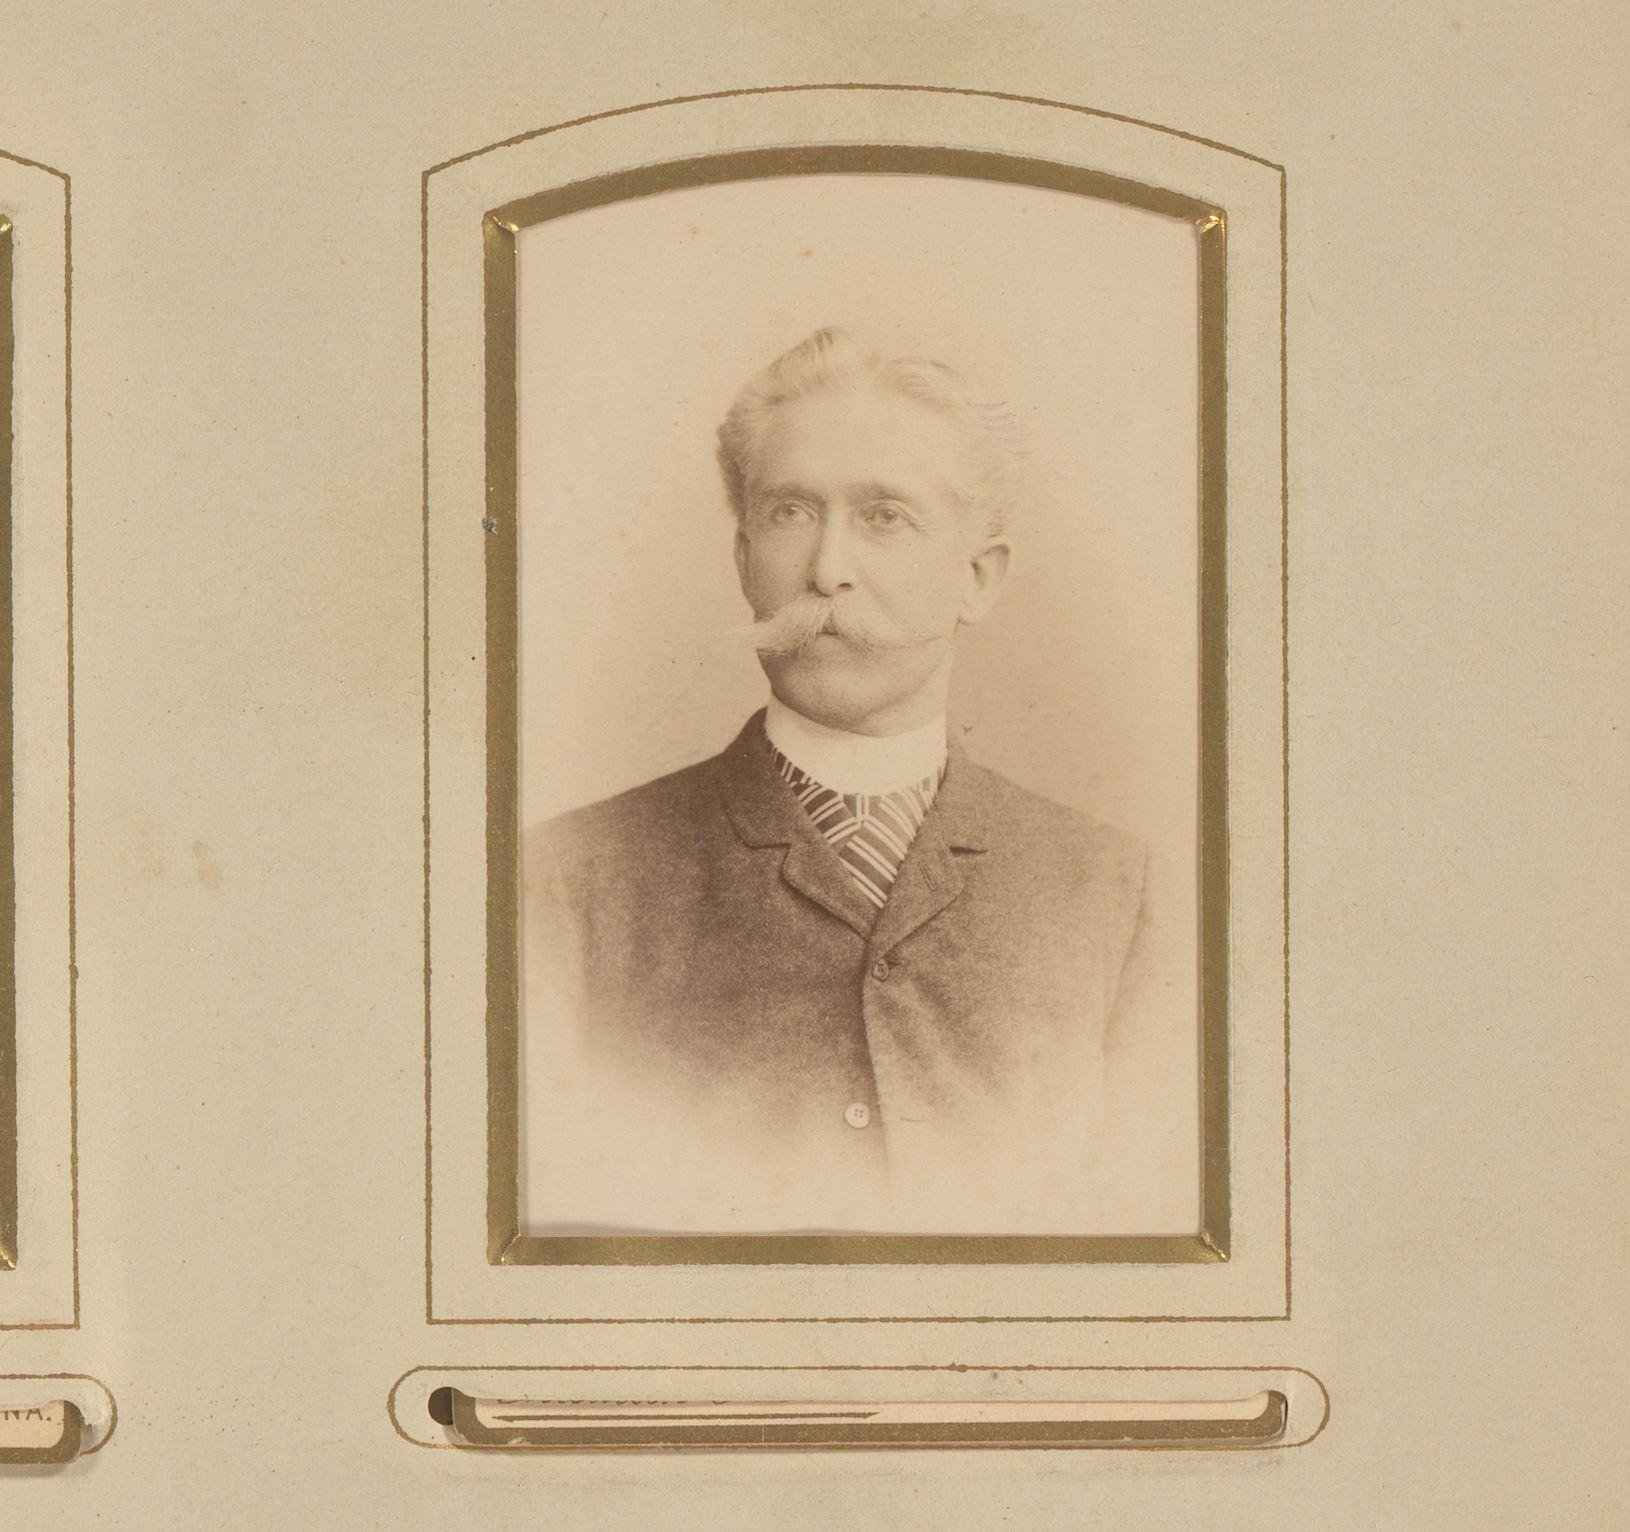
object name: carte de visite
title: Portret van een man met snor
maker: friedrich haack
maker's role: fotograaf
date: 1879-1900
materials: cardboard, photographic support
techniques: albumen print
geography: jena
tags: moustache, historical persons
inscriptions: inscription: ‘Grossherzogl. Sachs./ HOF-PHOTOGRAPH/ Friedrich Haack/ PRÄMIIRT/ LEIPZIG 1879./ Jena/ an der Promenade/ neben dem Gymnasium./ Für Nachbestellungen bleibt die Platte aufbewahrt.’